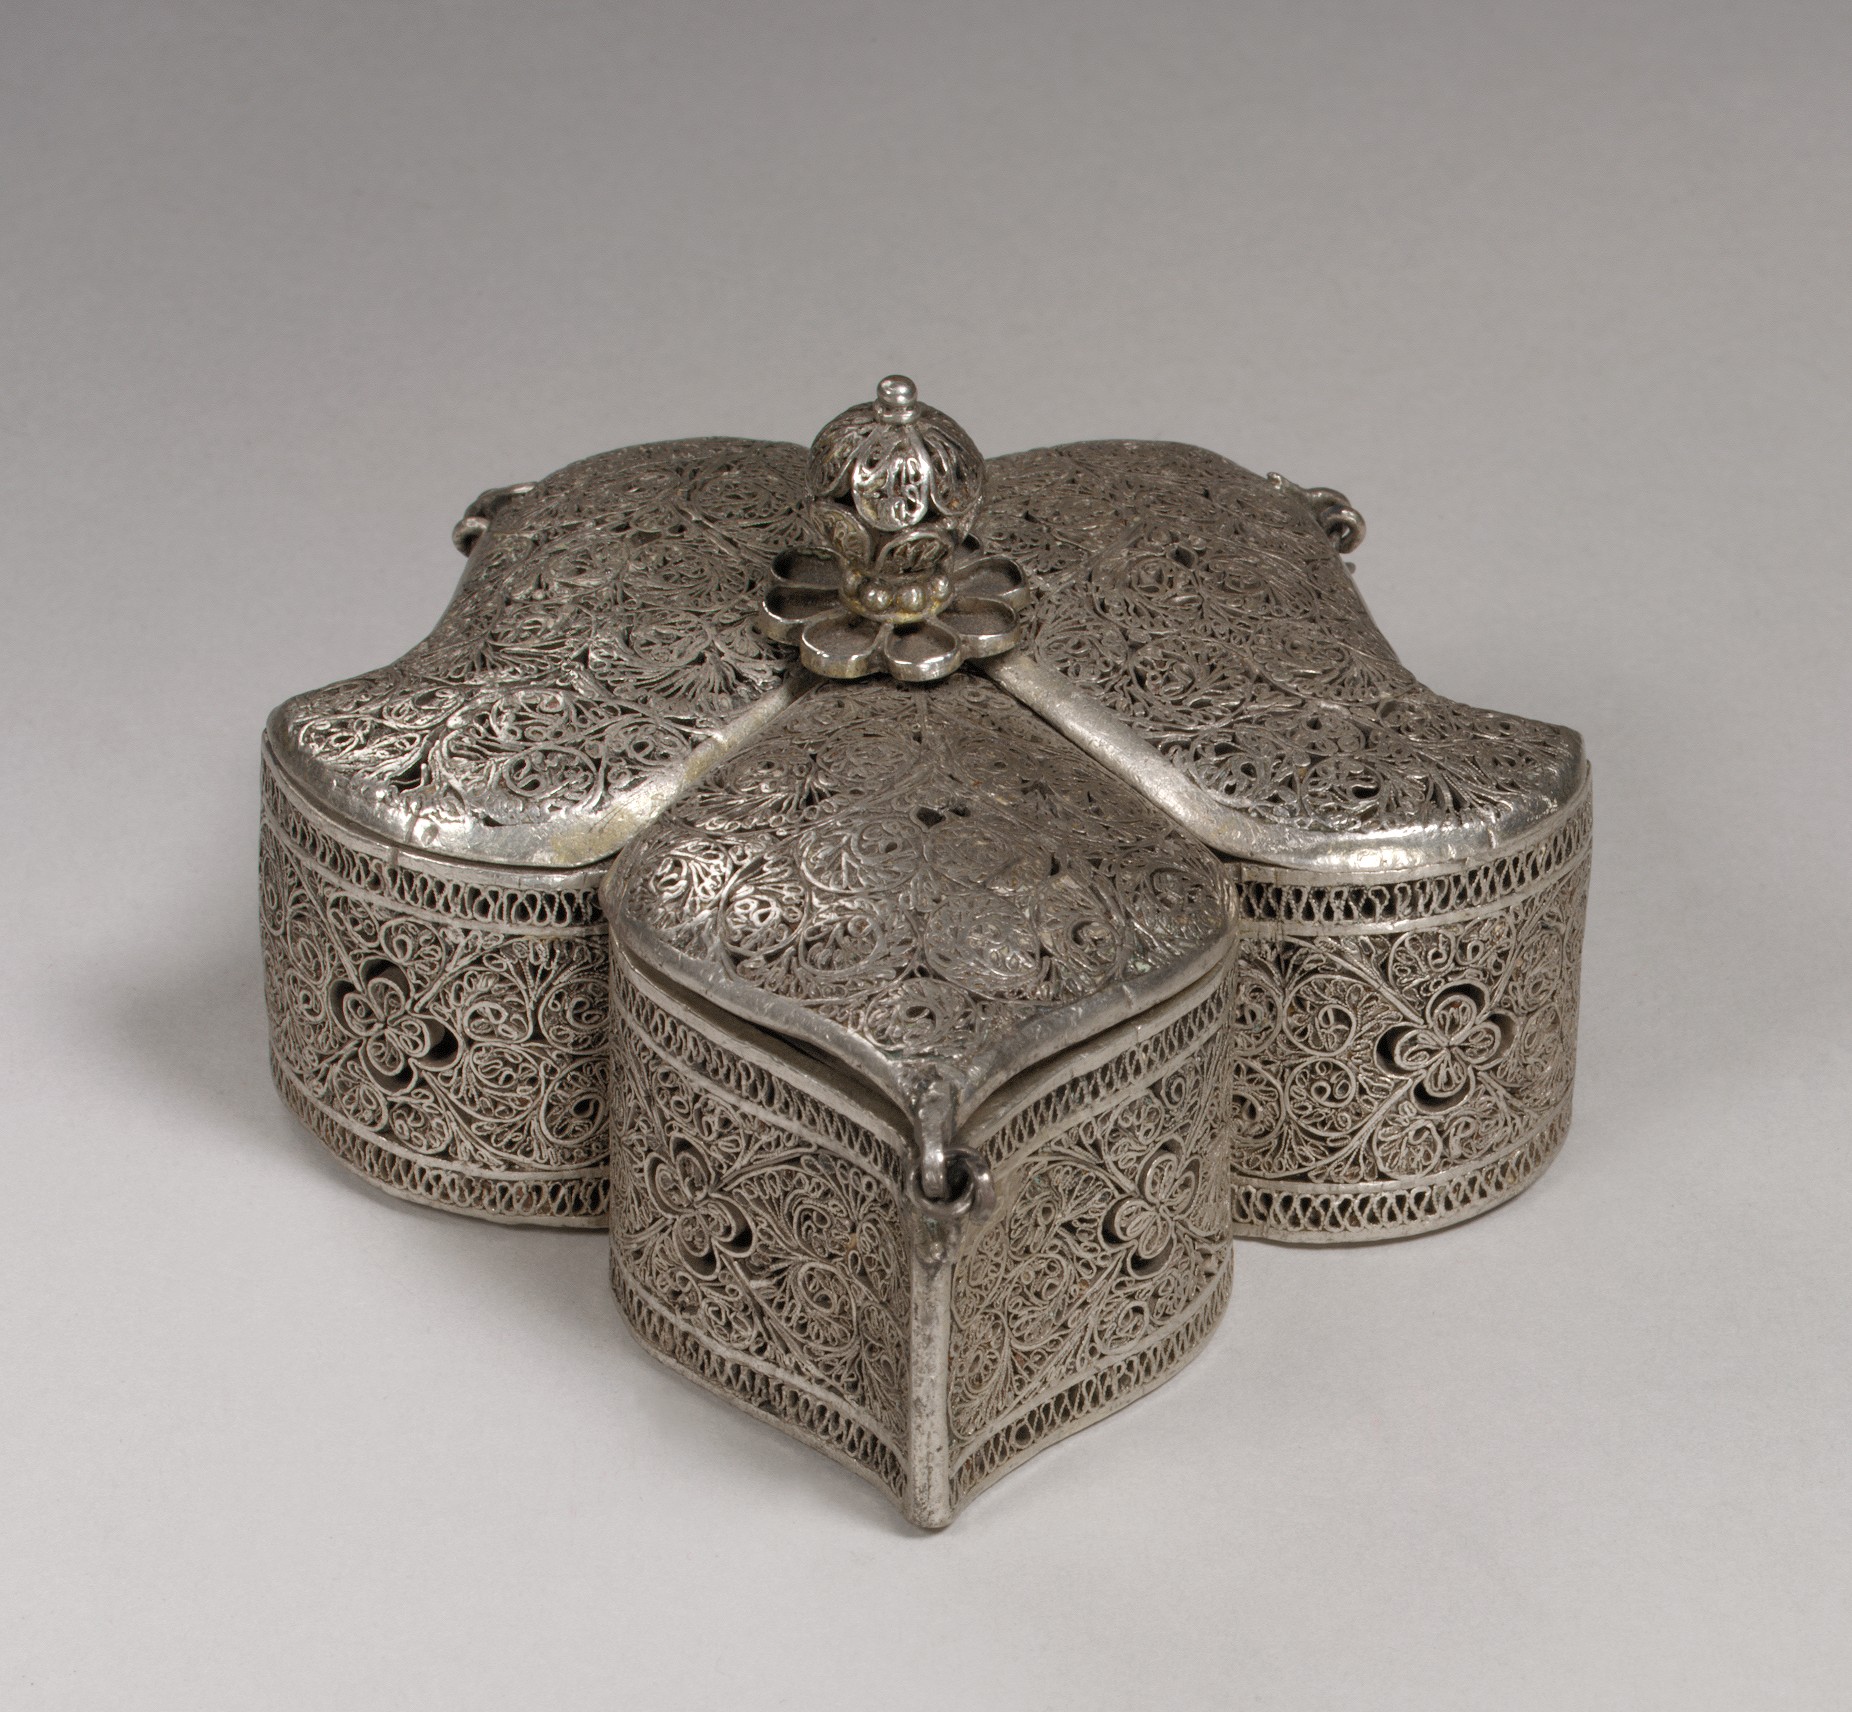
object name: box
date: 1801-1900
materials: silver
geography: india